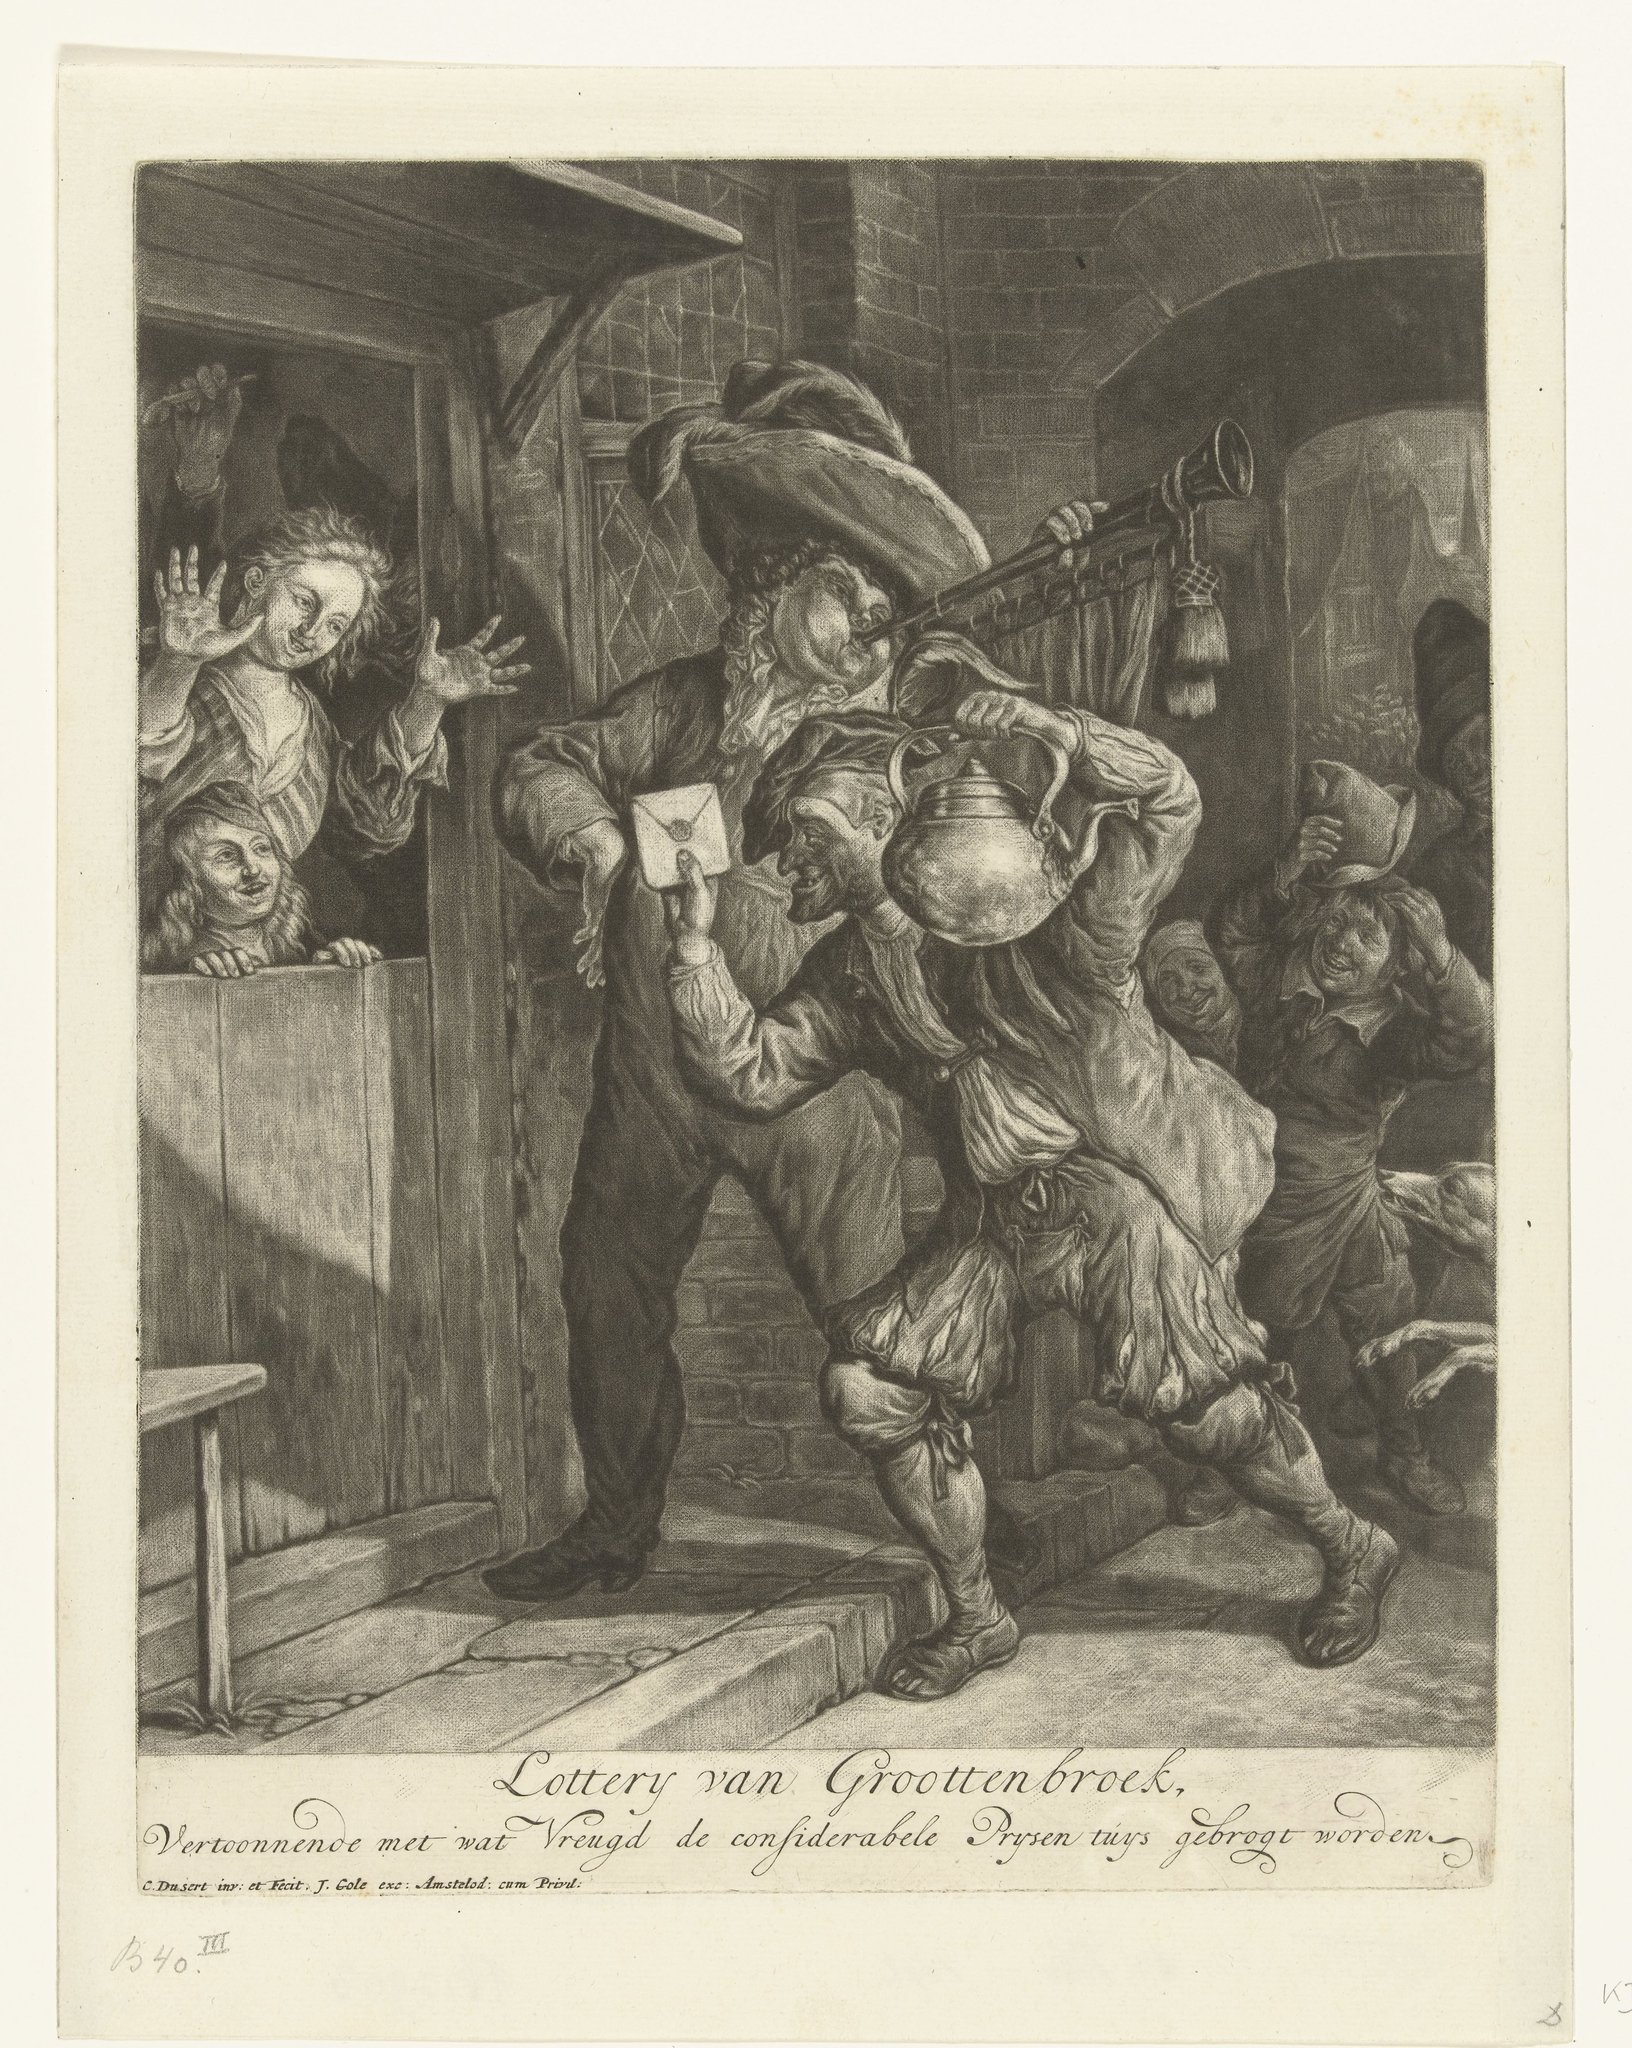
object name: print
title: Loterij van Grootebroek, 1694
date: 1694-1695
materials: paper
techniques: mezzotint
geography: amsterdam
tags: raffle, lottery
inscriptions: collector's mark: Lugt 240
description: De loterij gehouden voor de slachtoffers van de grote brand in het dorp Grootebroek (bij Enkhuizen) op 20 augustus 1694. Een man bezorgt een ketel en een verzegelde brief bij de prijswinnaars van de loterij.